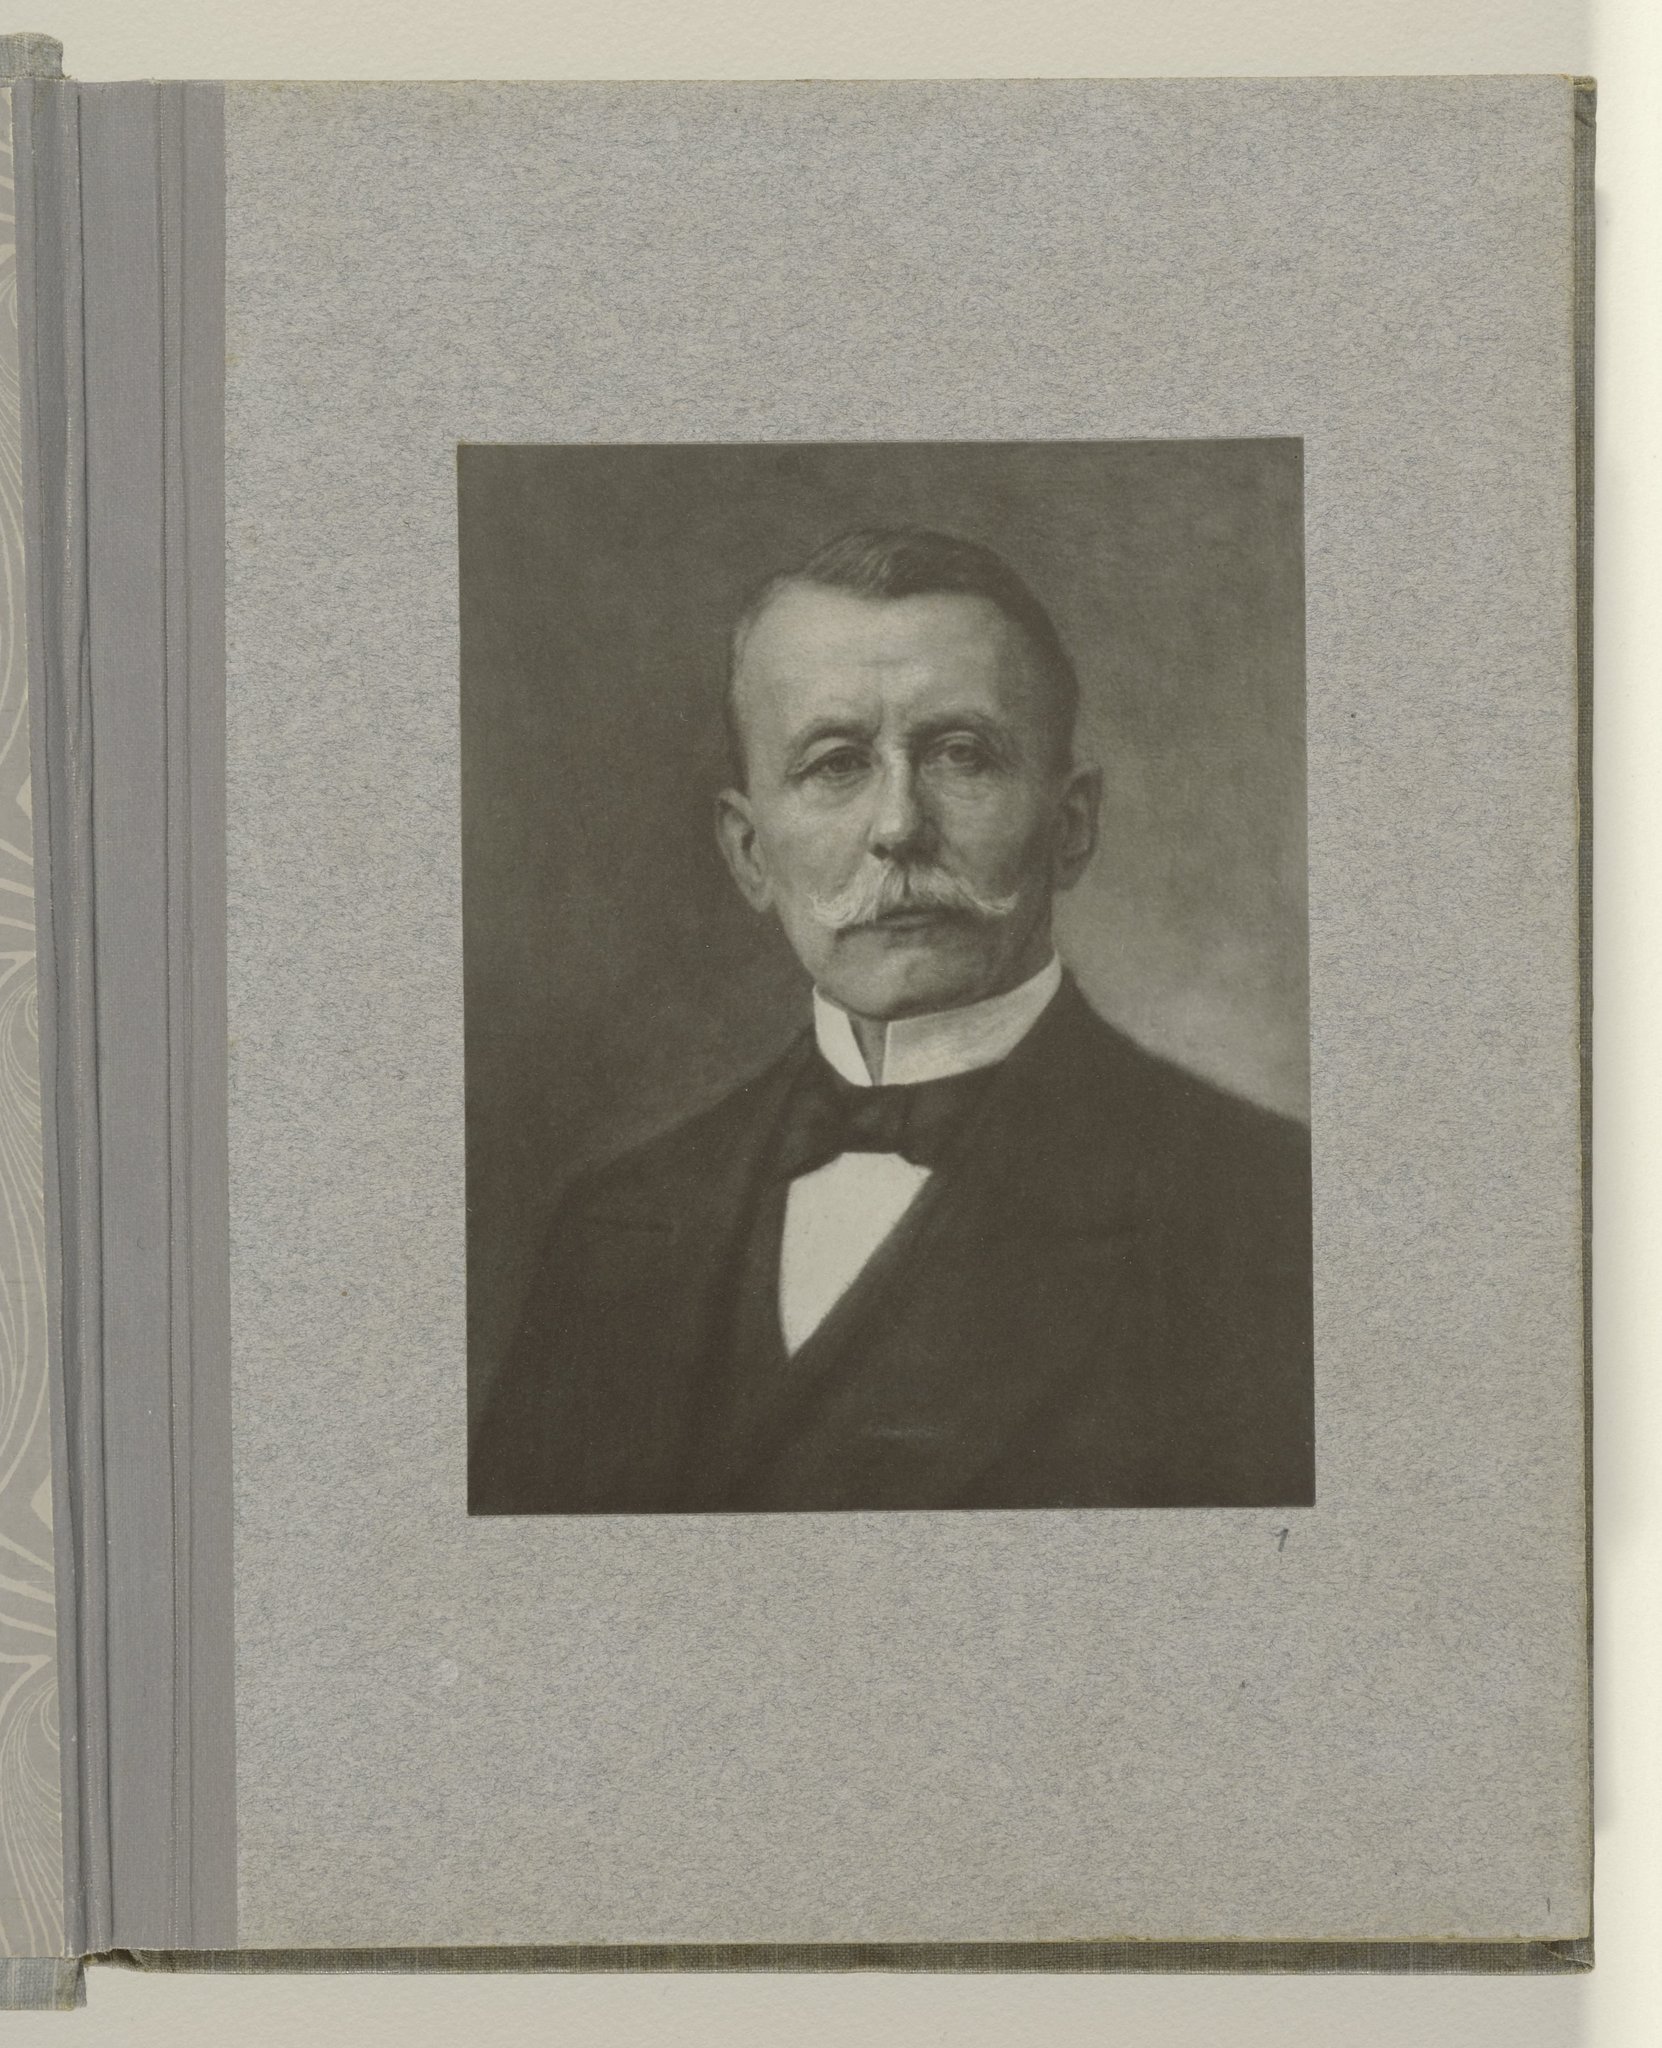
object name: photograph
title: Fotoreproduktie van een door Jan Veth postuum geschilderd portret van J.B. Aug. Kessler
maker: geldolph adriaan kessler (dolph)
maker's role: fotograaf, industrieel, voetballer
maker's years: 1884-1945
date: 1900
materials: paper, photographic support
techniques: gelatin silver print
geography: netherlands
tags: batavia, naples, jean baptiste august kessler (1853-1900)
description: Schilderij hangt in kantoor Shell, Den Haag